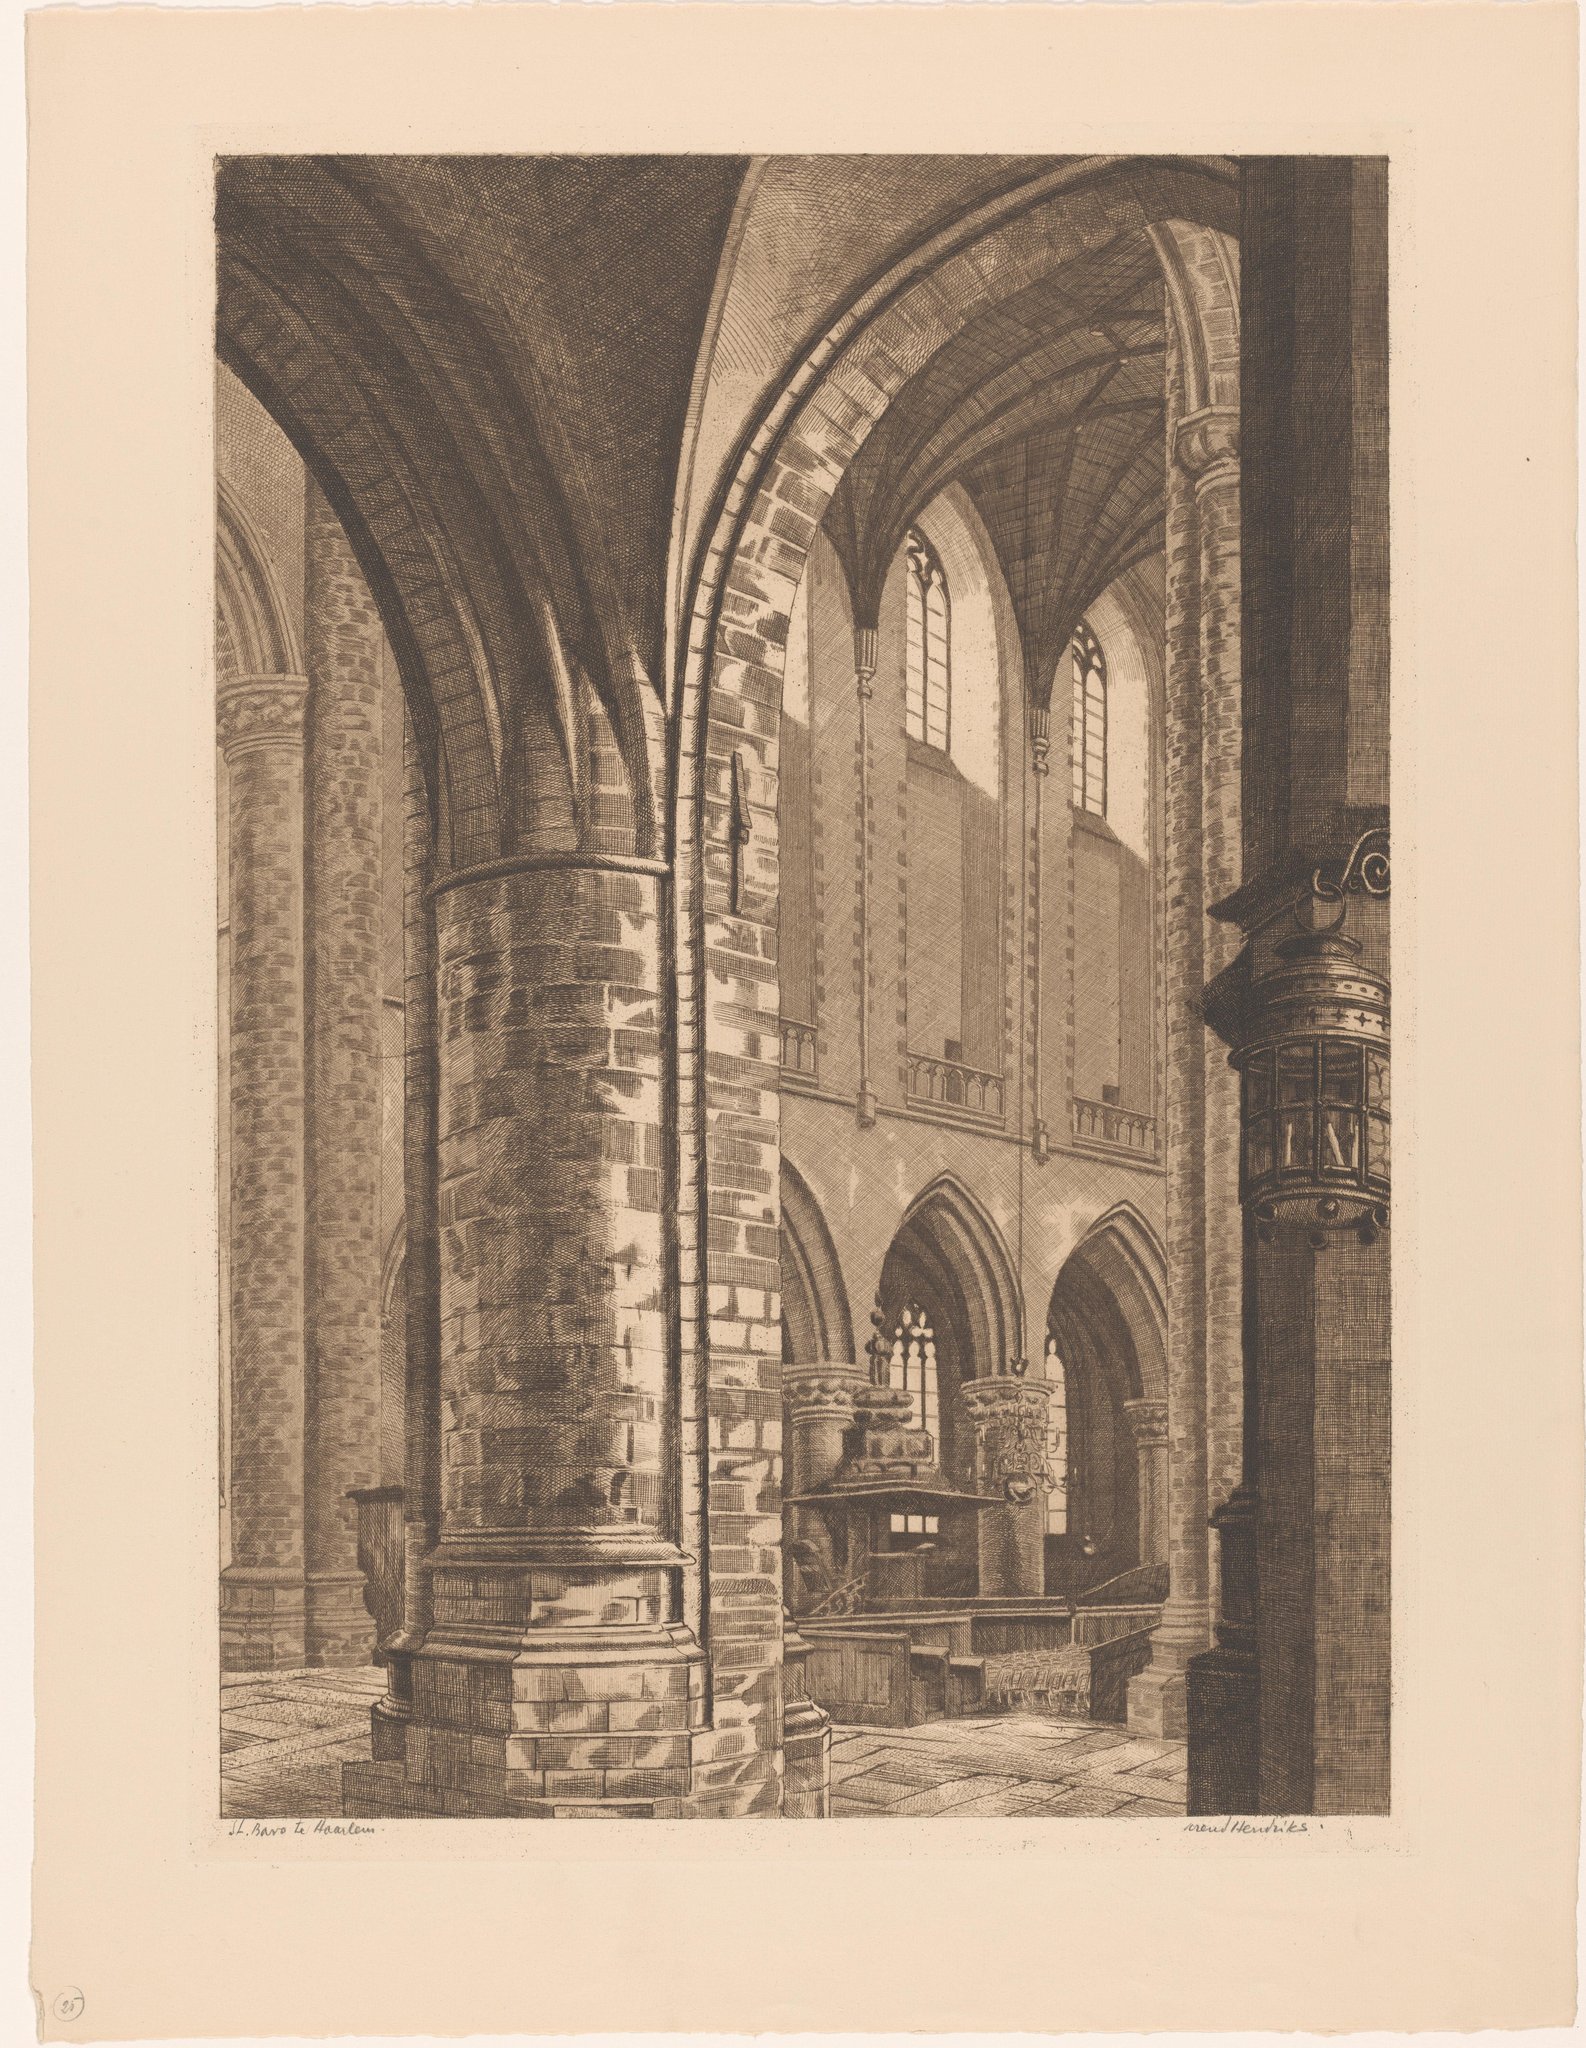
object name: print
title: St. Bavo te Haarlem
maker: arend hendriks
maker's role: print maker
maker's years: 1901-1951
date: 1911-1931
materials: paper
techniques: etching, intaglio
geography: netherlands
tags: interior of church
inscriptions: collector's mark: Lugt 2228